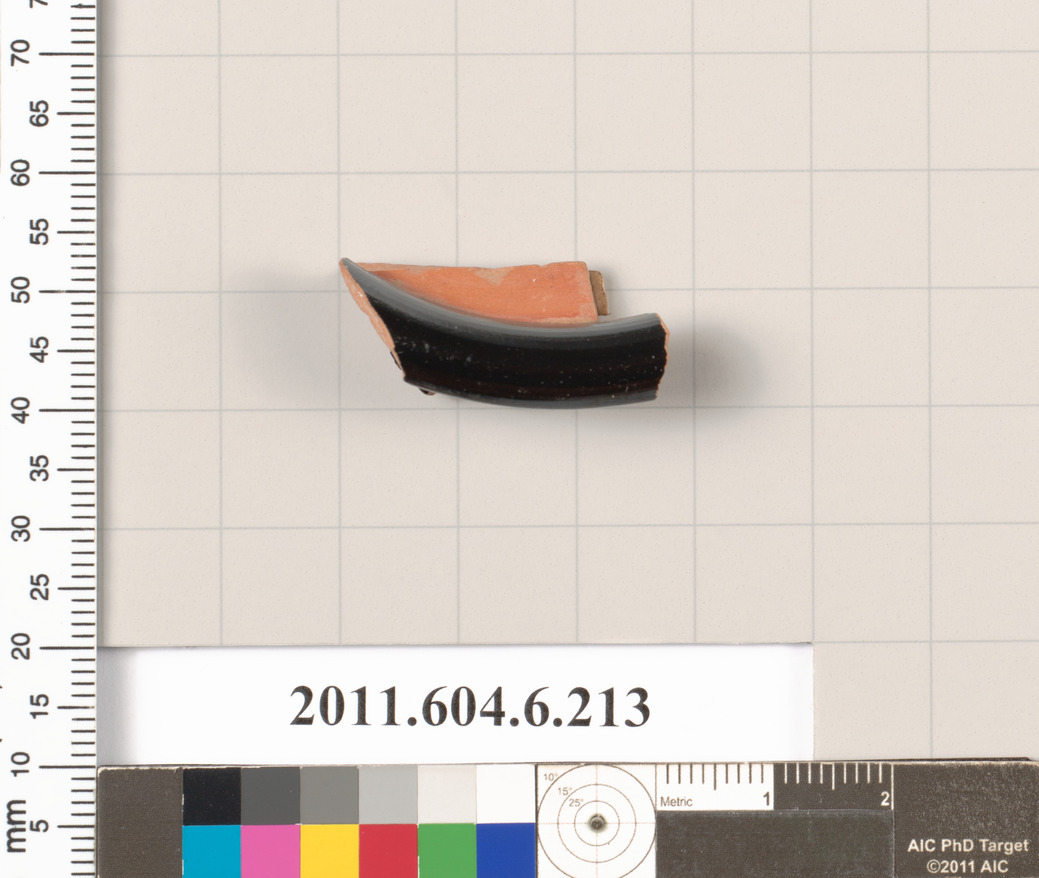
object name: skyphos fragment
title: Terracotta fragment of a skyphos (deep drinking cup)?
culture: greek, attic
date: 500-401 BCE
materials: terracotta